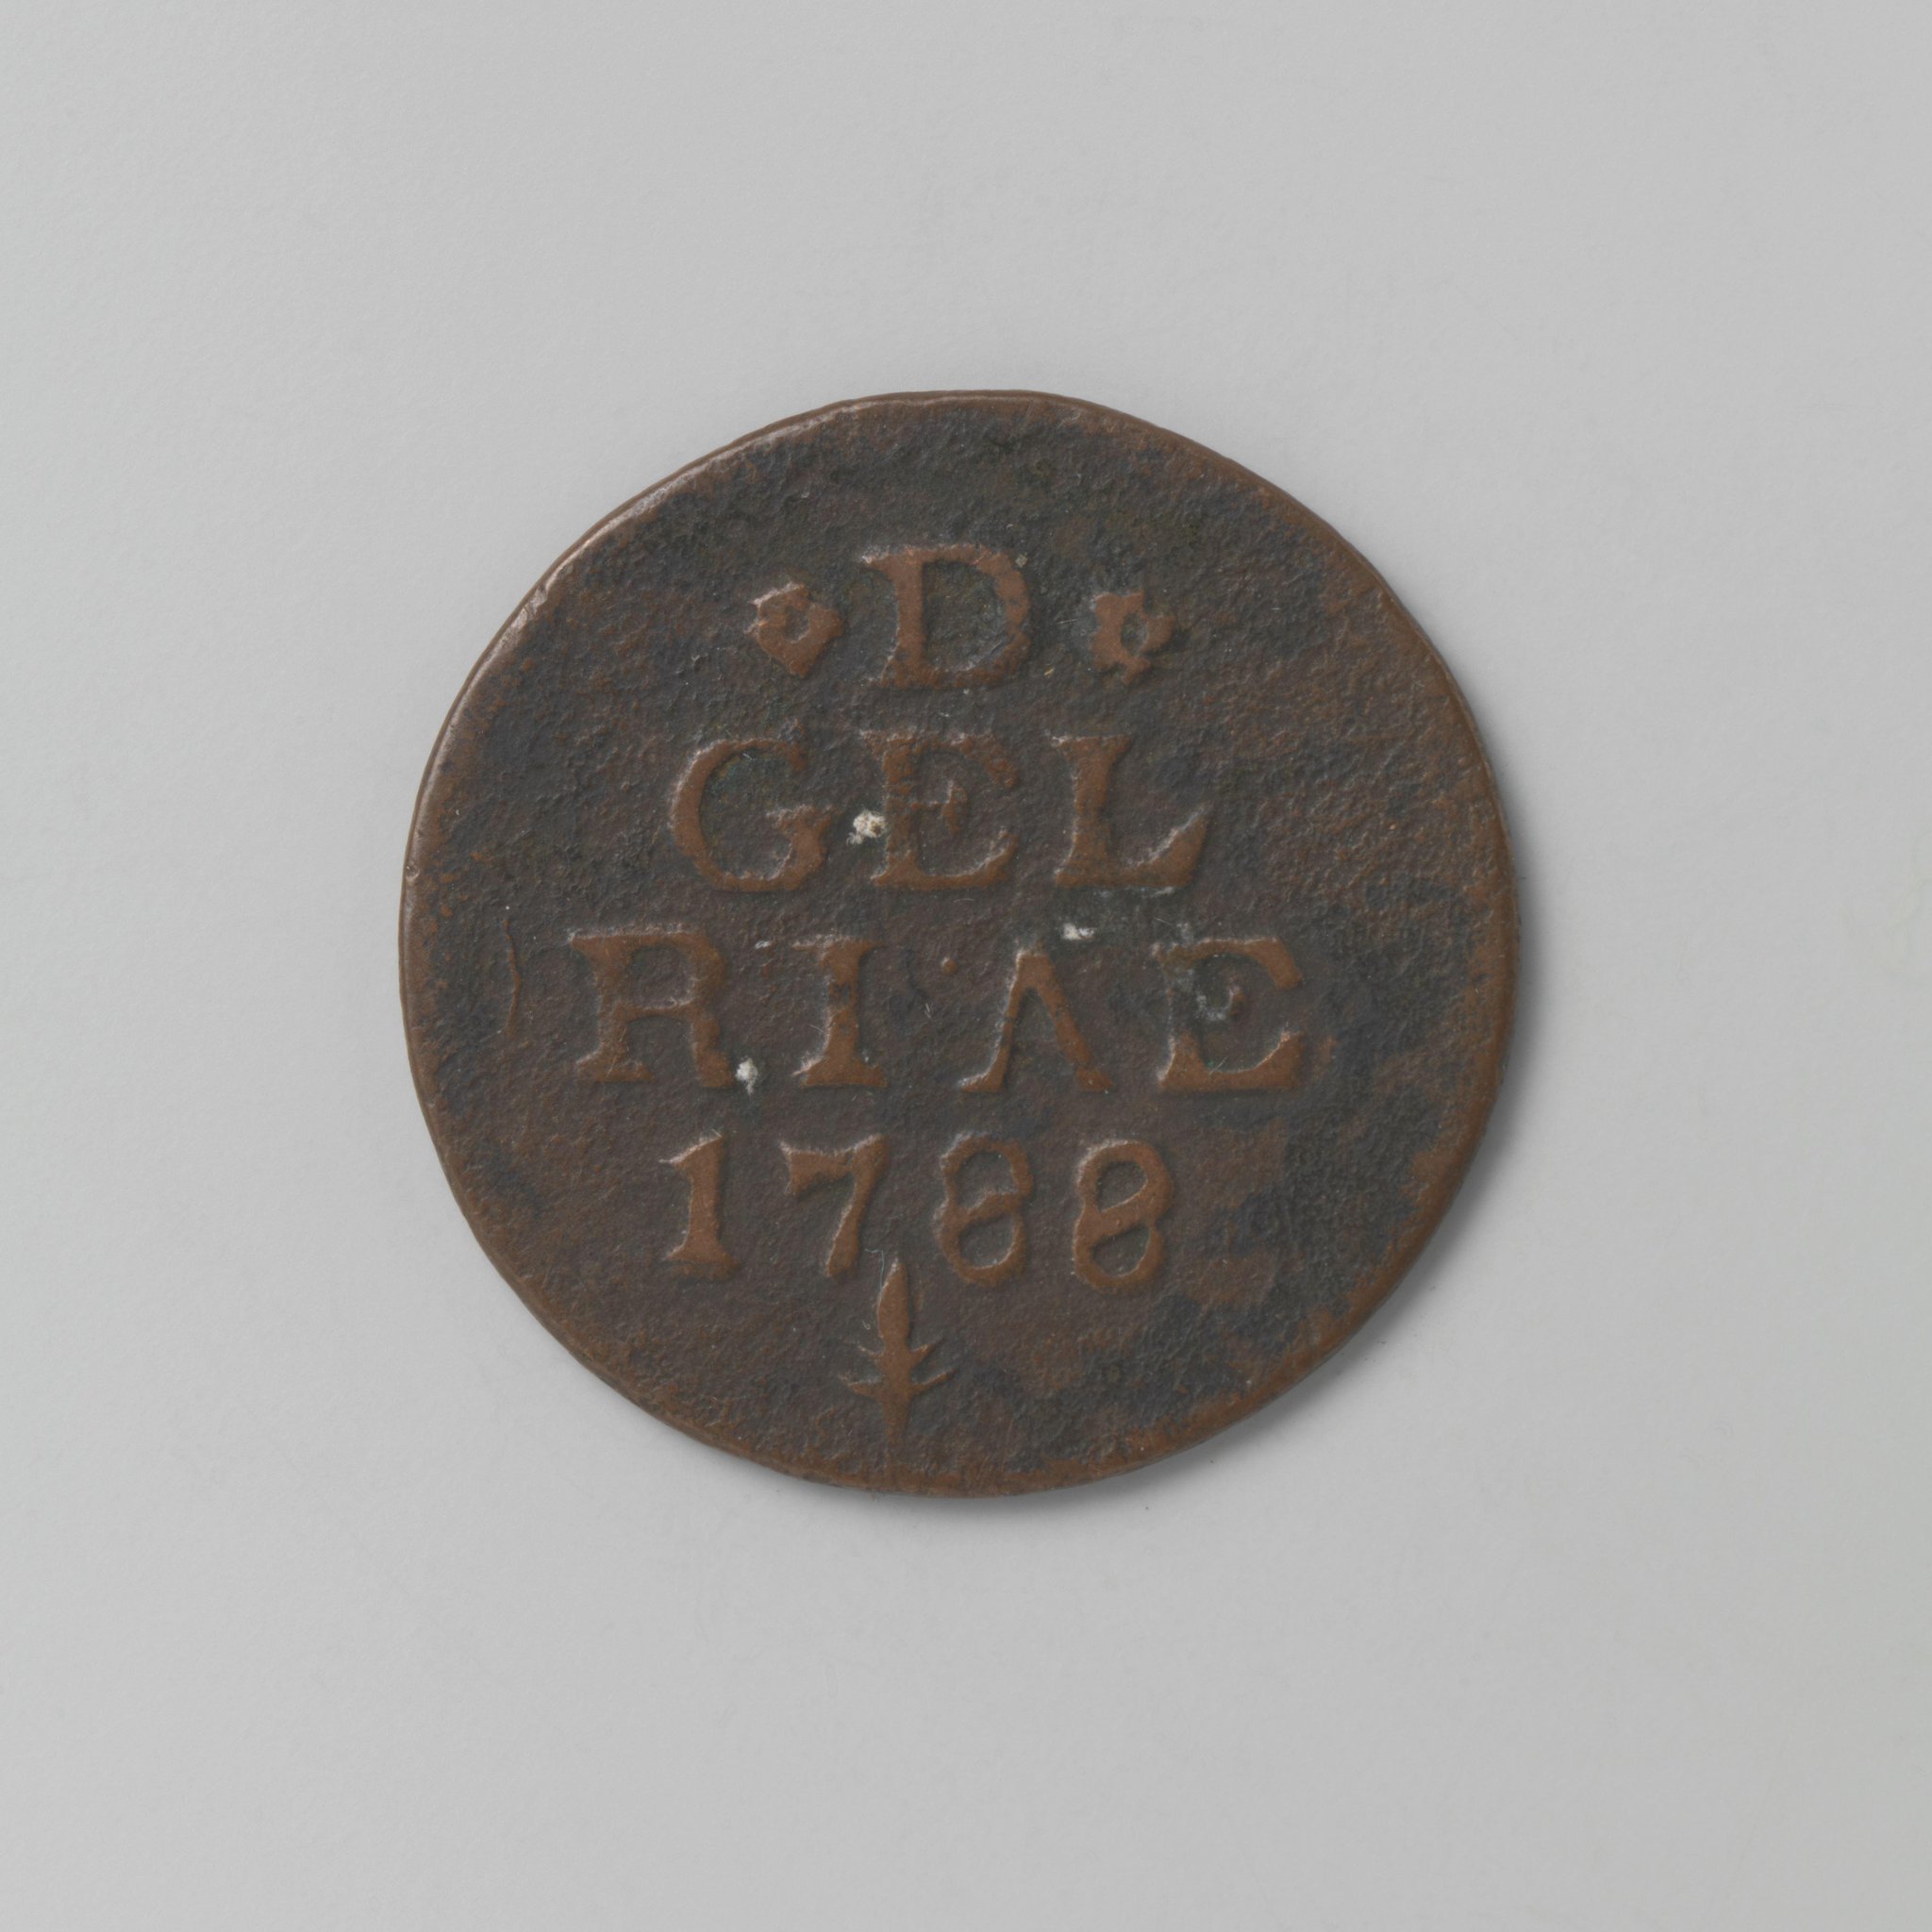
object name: duit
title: Gelderland, duit, 1788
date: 1788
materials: copper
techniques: striking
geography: harderwijk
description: Koperen munt. Voorzijde: in drie regels D/GEL/RIAE, daaronder jaartal en muntmeesterteken. Keerzijde: gekroond Gelders wapenschild.